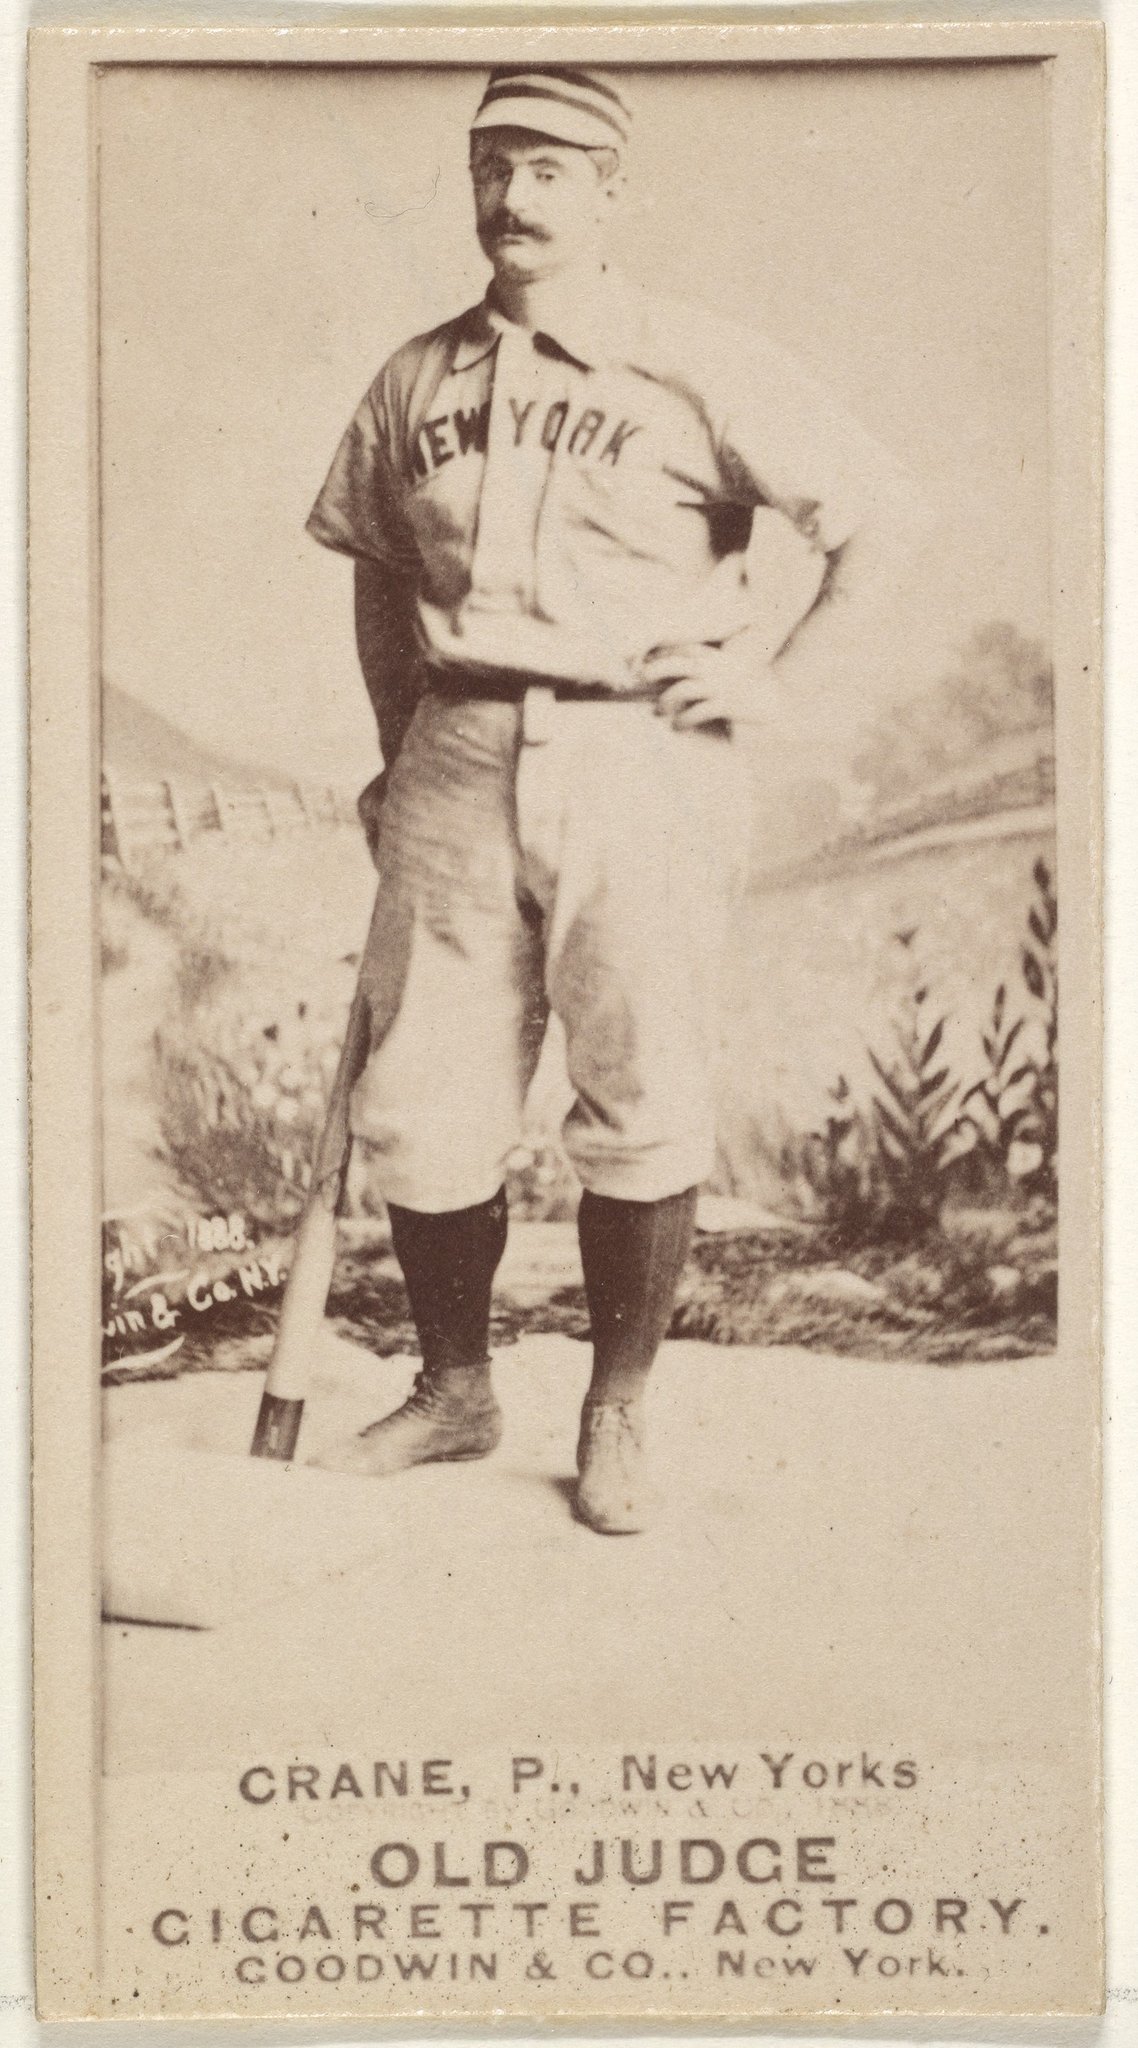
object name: baseball card, photograph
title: Ed Crane, Pitcher, New York, from the Old Judge series (N172) for Old Judge Cigarettes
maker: goodwin & company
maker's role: publisher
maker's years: 1850-1950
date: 1888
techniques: albumen silver print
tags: men,portraits,baseball,athletes